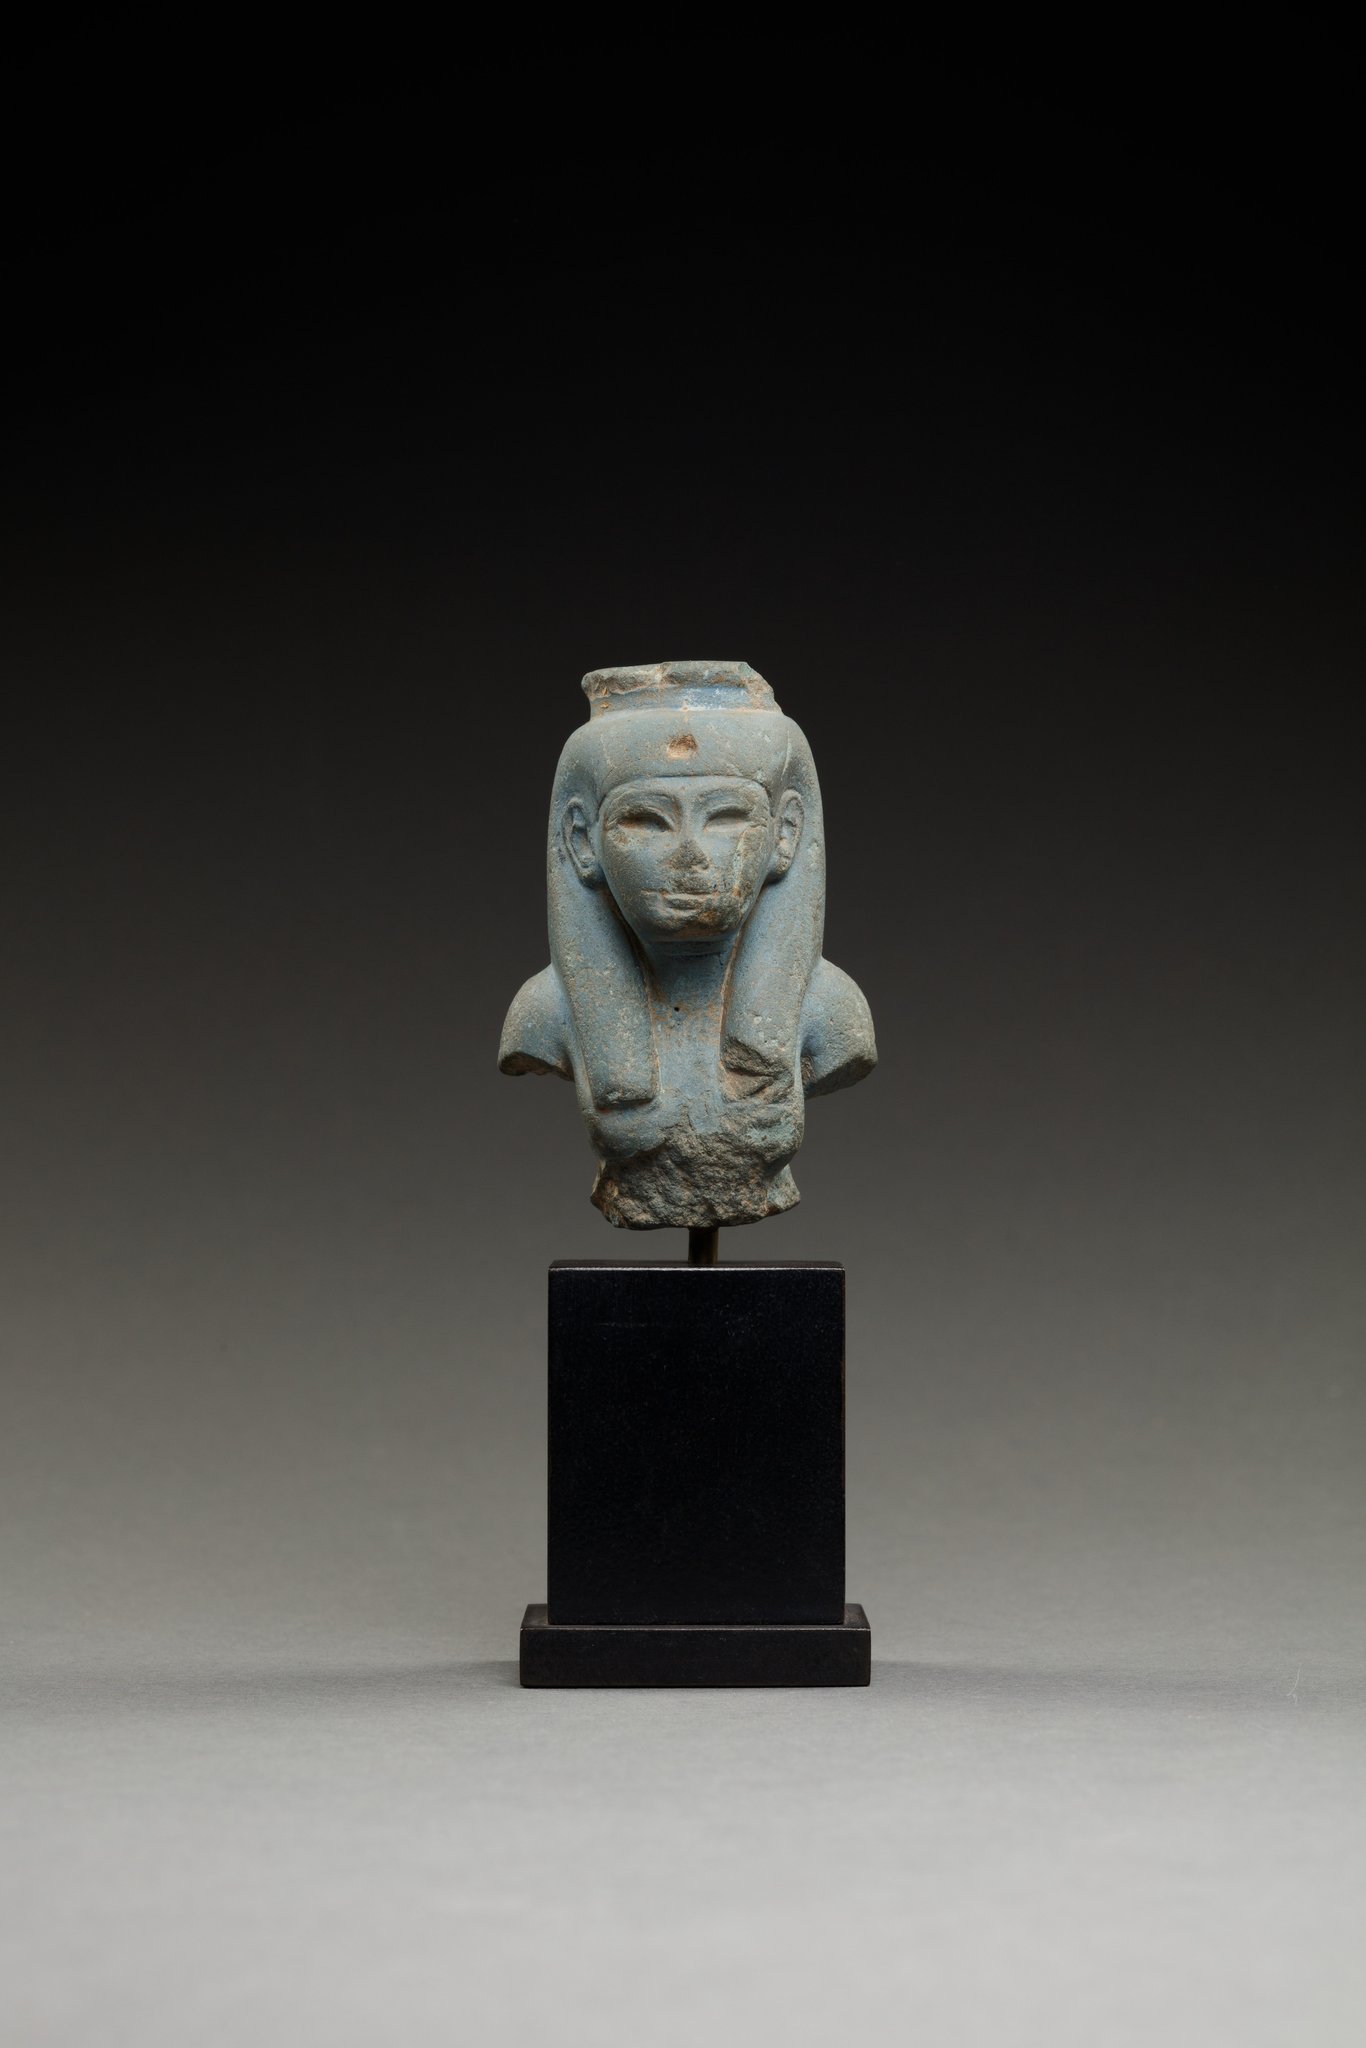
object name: upper part of isi, from a figure of the goddess nursing horus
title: Upper part of Isis, from a figure of the goddess nursing Horus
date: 945-700 BCE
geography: egypt